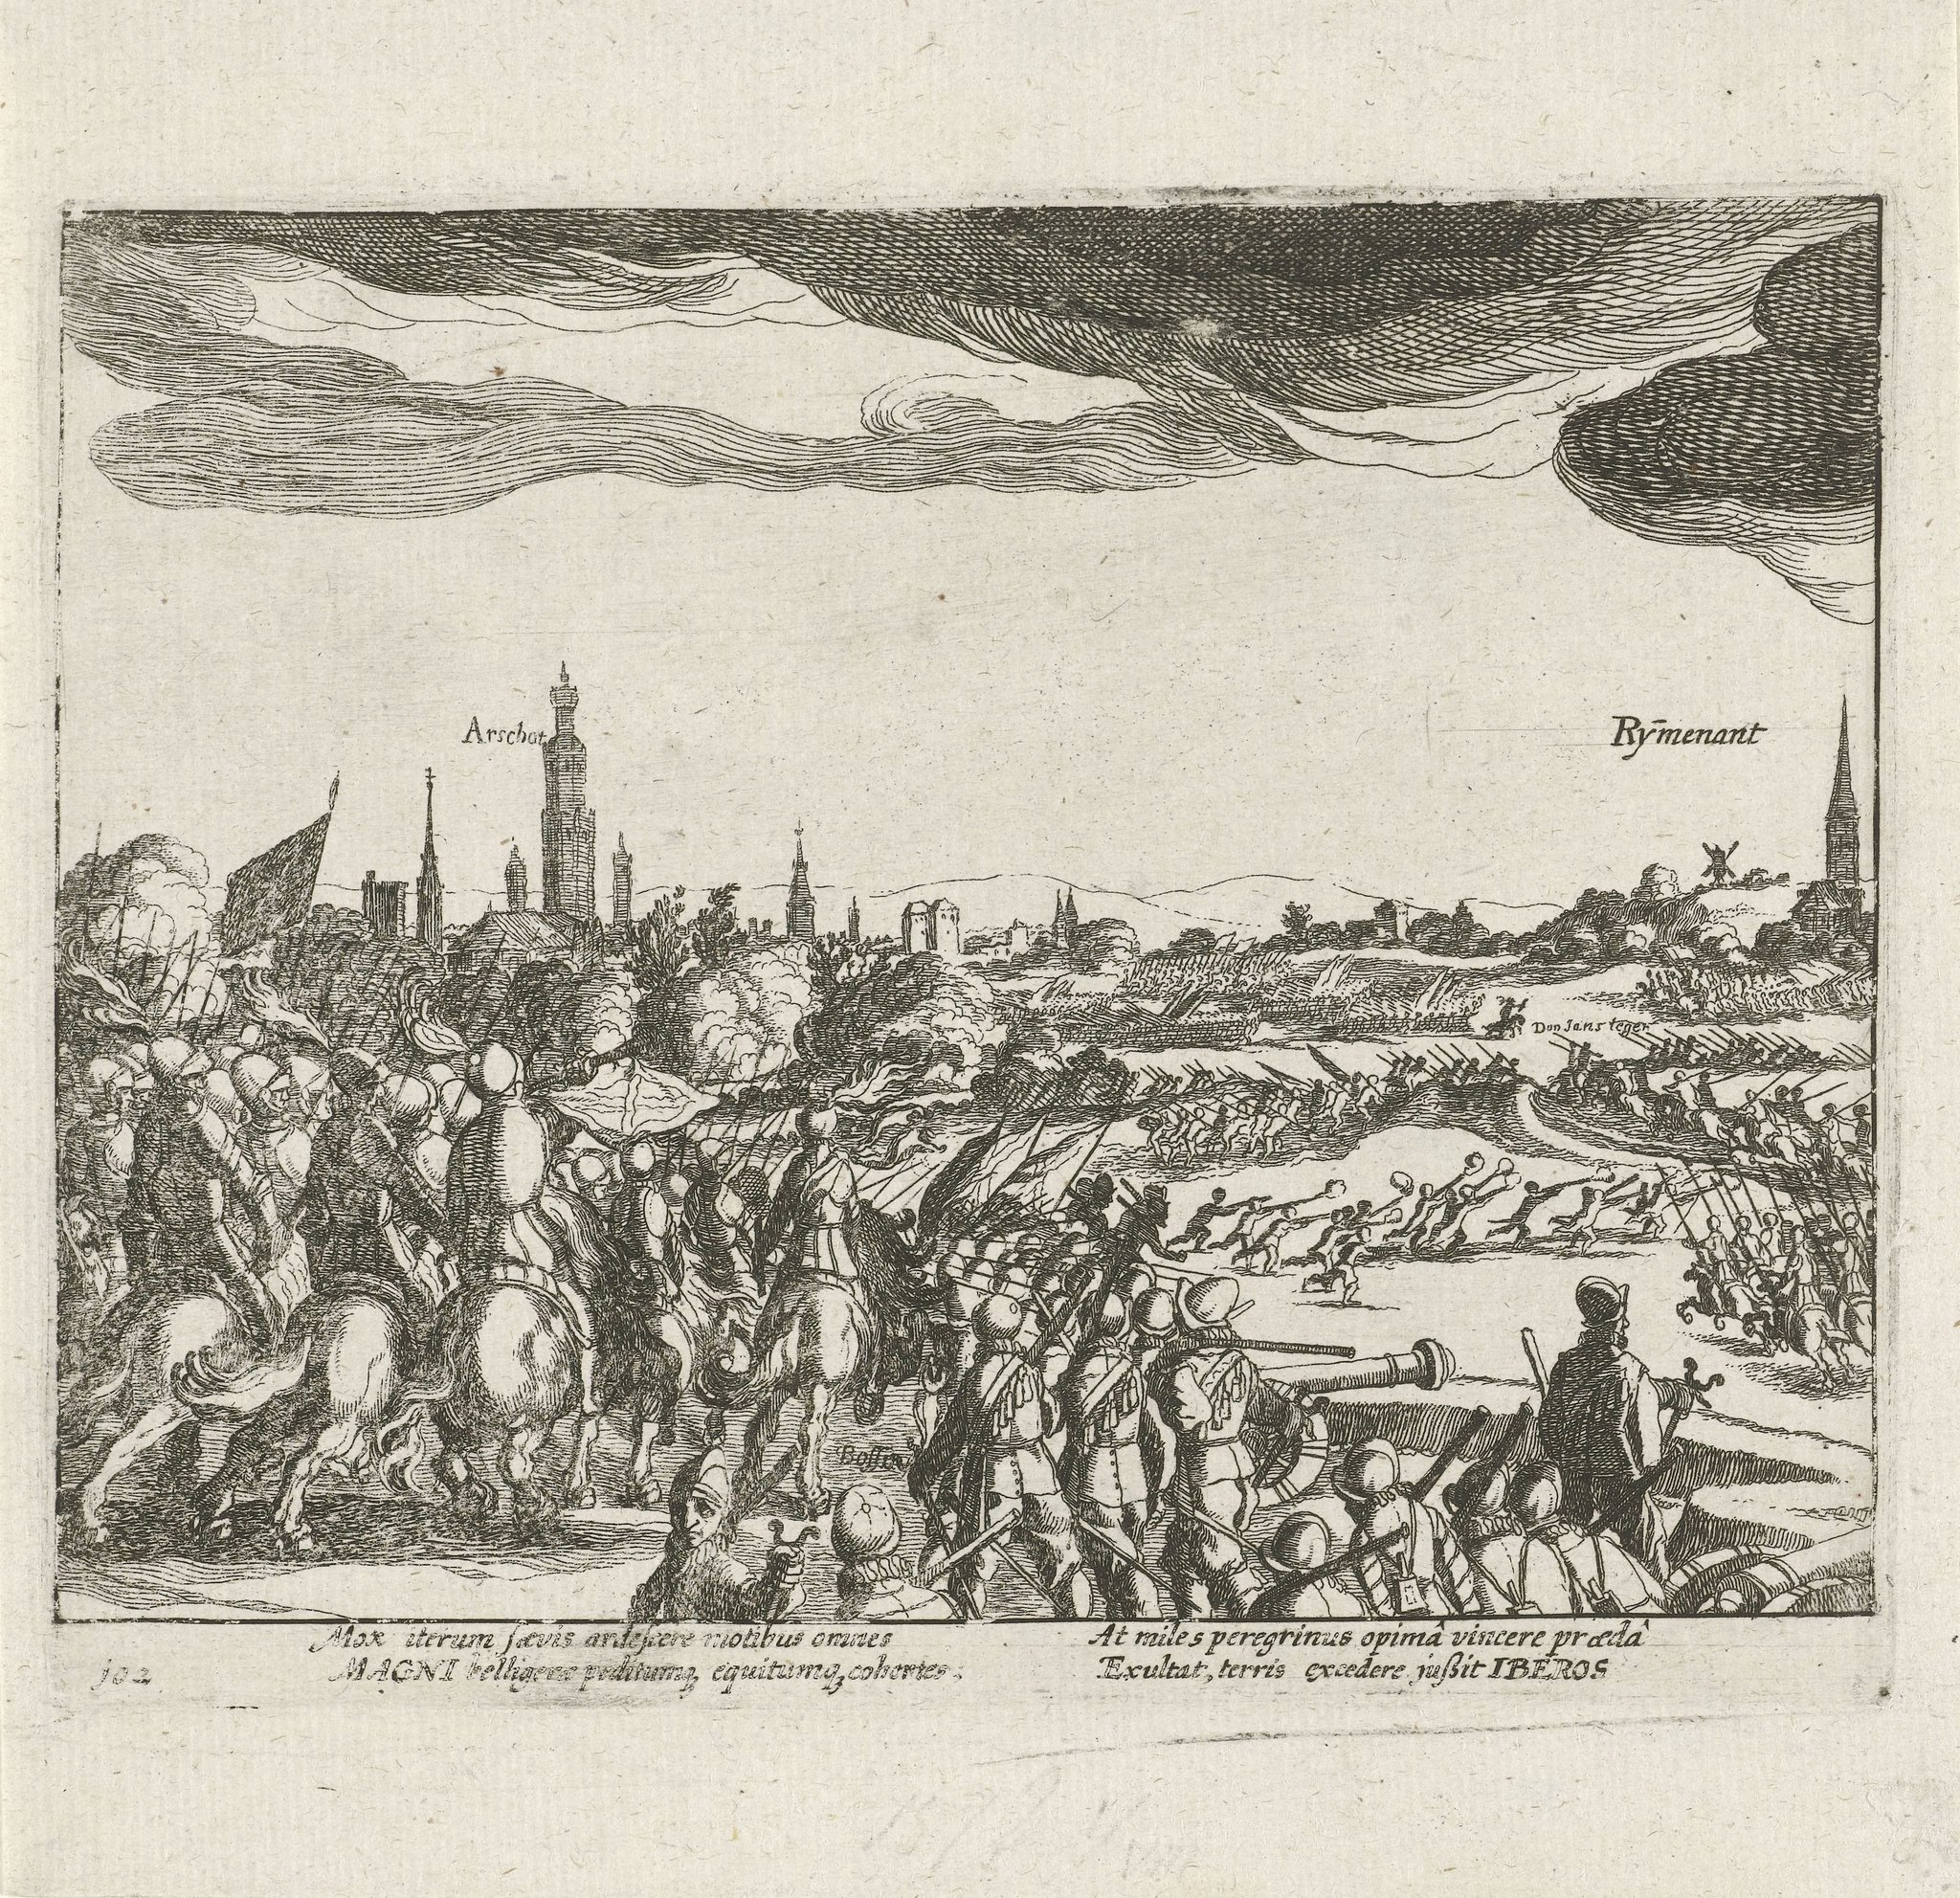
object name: print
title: Slag bij Rijmenam, 1578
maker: simon frisius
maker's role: print maker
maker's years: 1570-1628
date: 1613-1615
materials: paper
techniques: etching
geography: northern netherlands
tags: battle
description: Veldslag bij Rijmenam tussen het Staatse leger onder Bossu en de troepen van Don Juan, 1 augustus 1578. In de verte de plaatsen Aarschot en Rijmenam. Met onderschrift van 4 regels in het Latijn. Genummerd: 102. Onbedrukt op achterzijde.